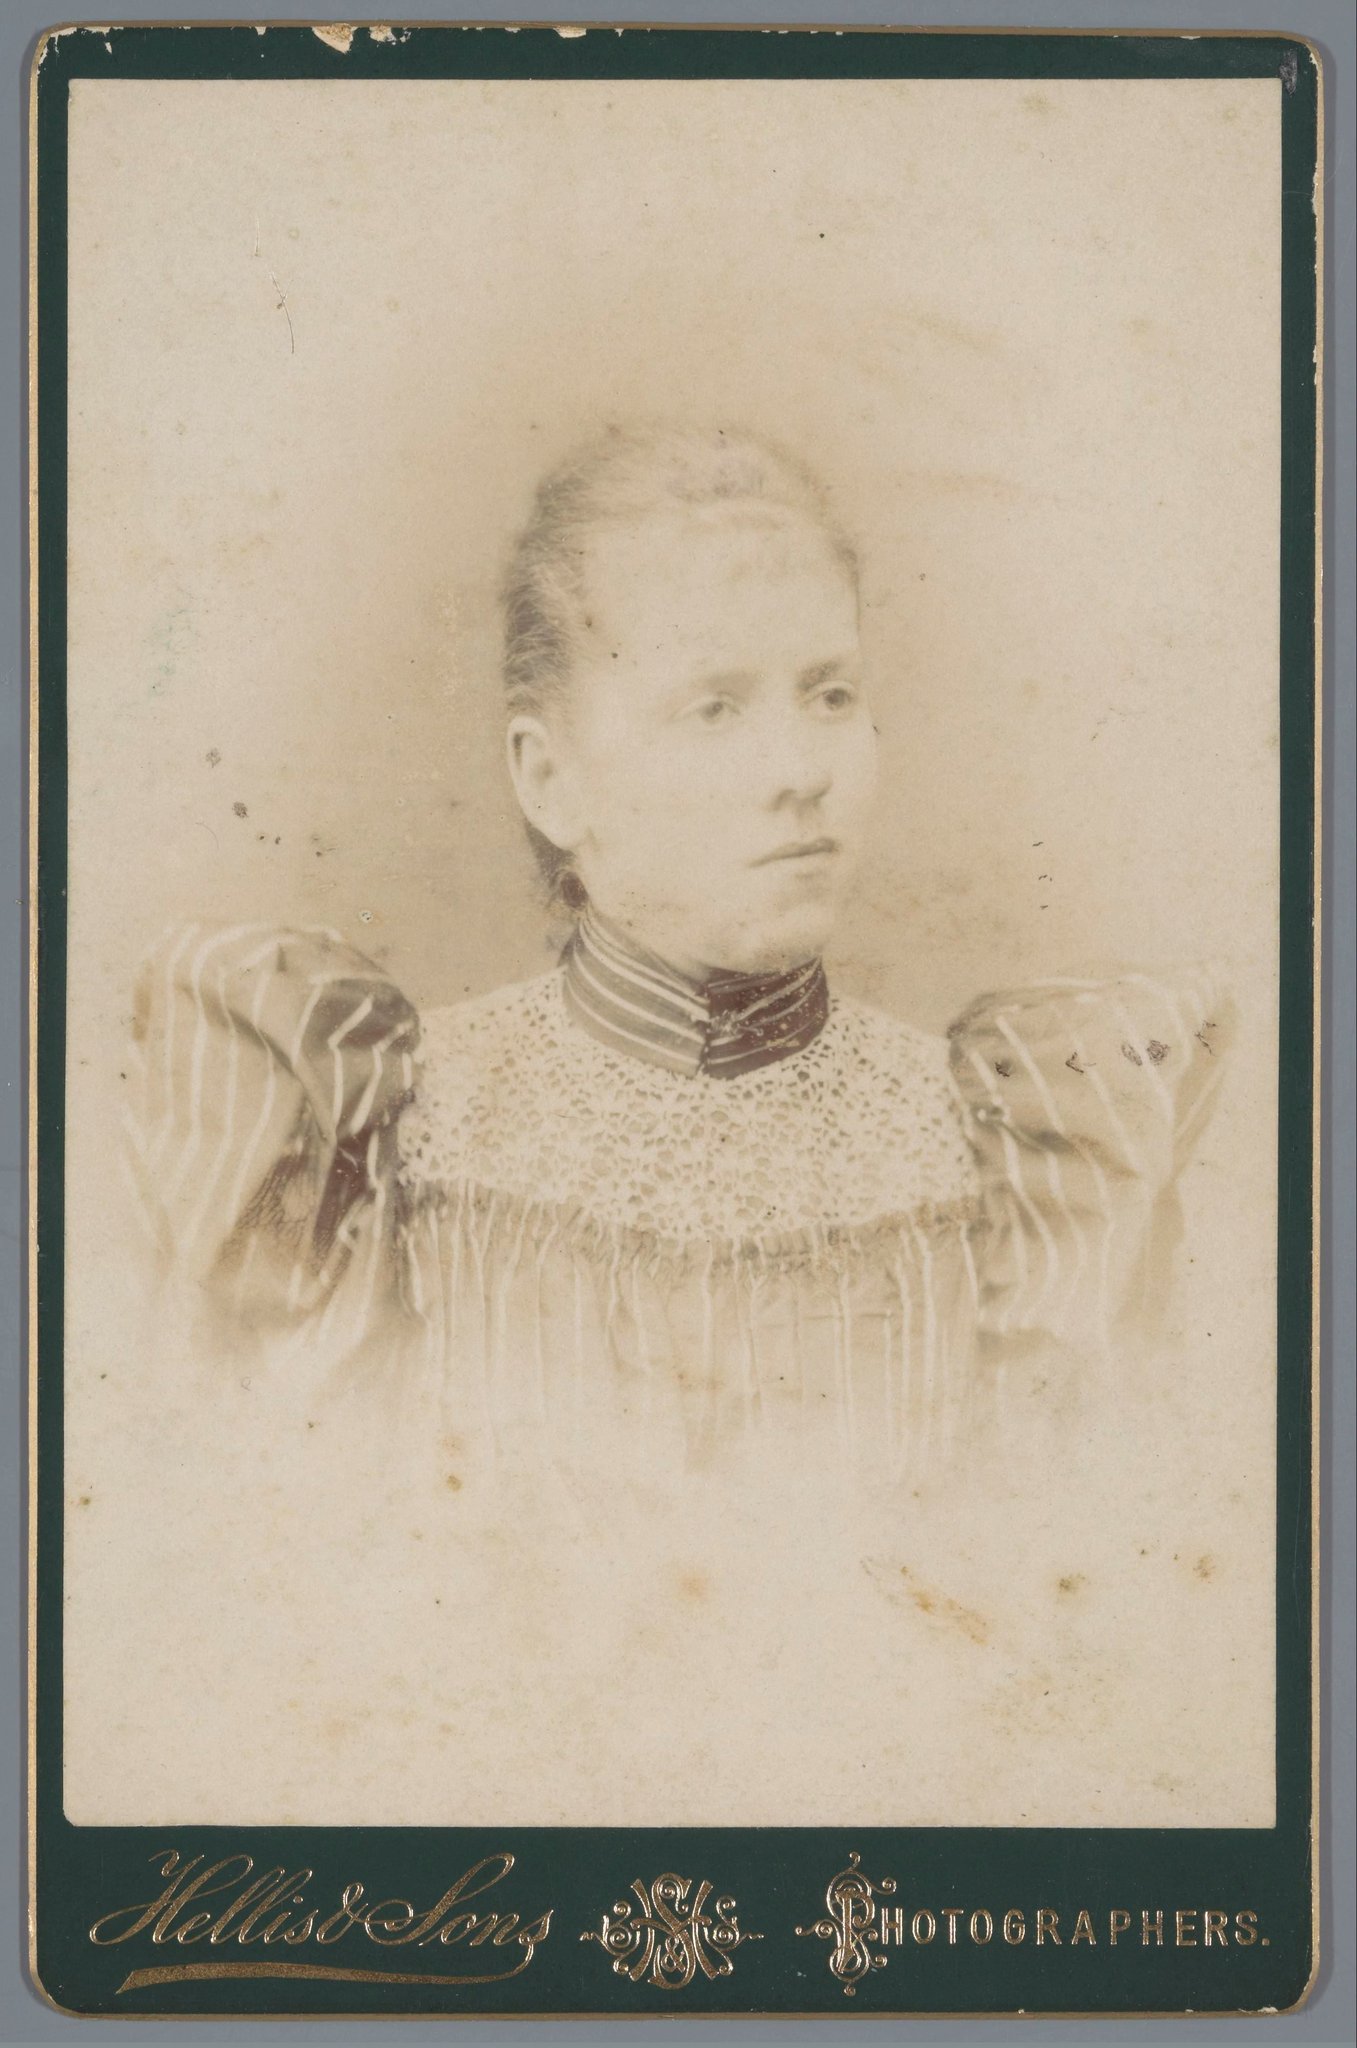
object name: cabinet photograph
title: Portret van een onbekende vrouw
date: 1875-1890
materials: cardboard, photographic support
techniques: albumen print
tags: adult woman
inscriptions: inscription: ‘Hellis & Sons Photographers’, inscription: ‘211 & 213, Regent Street, W (...) London established over 25 years’